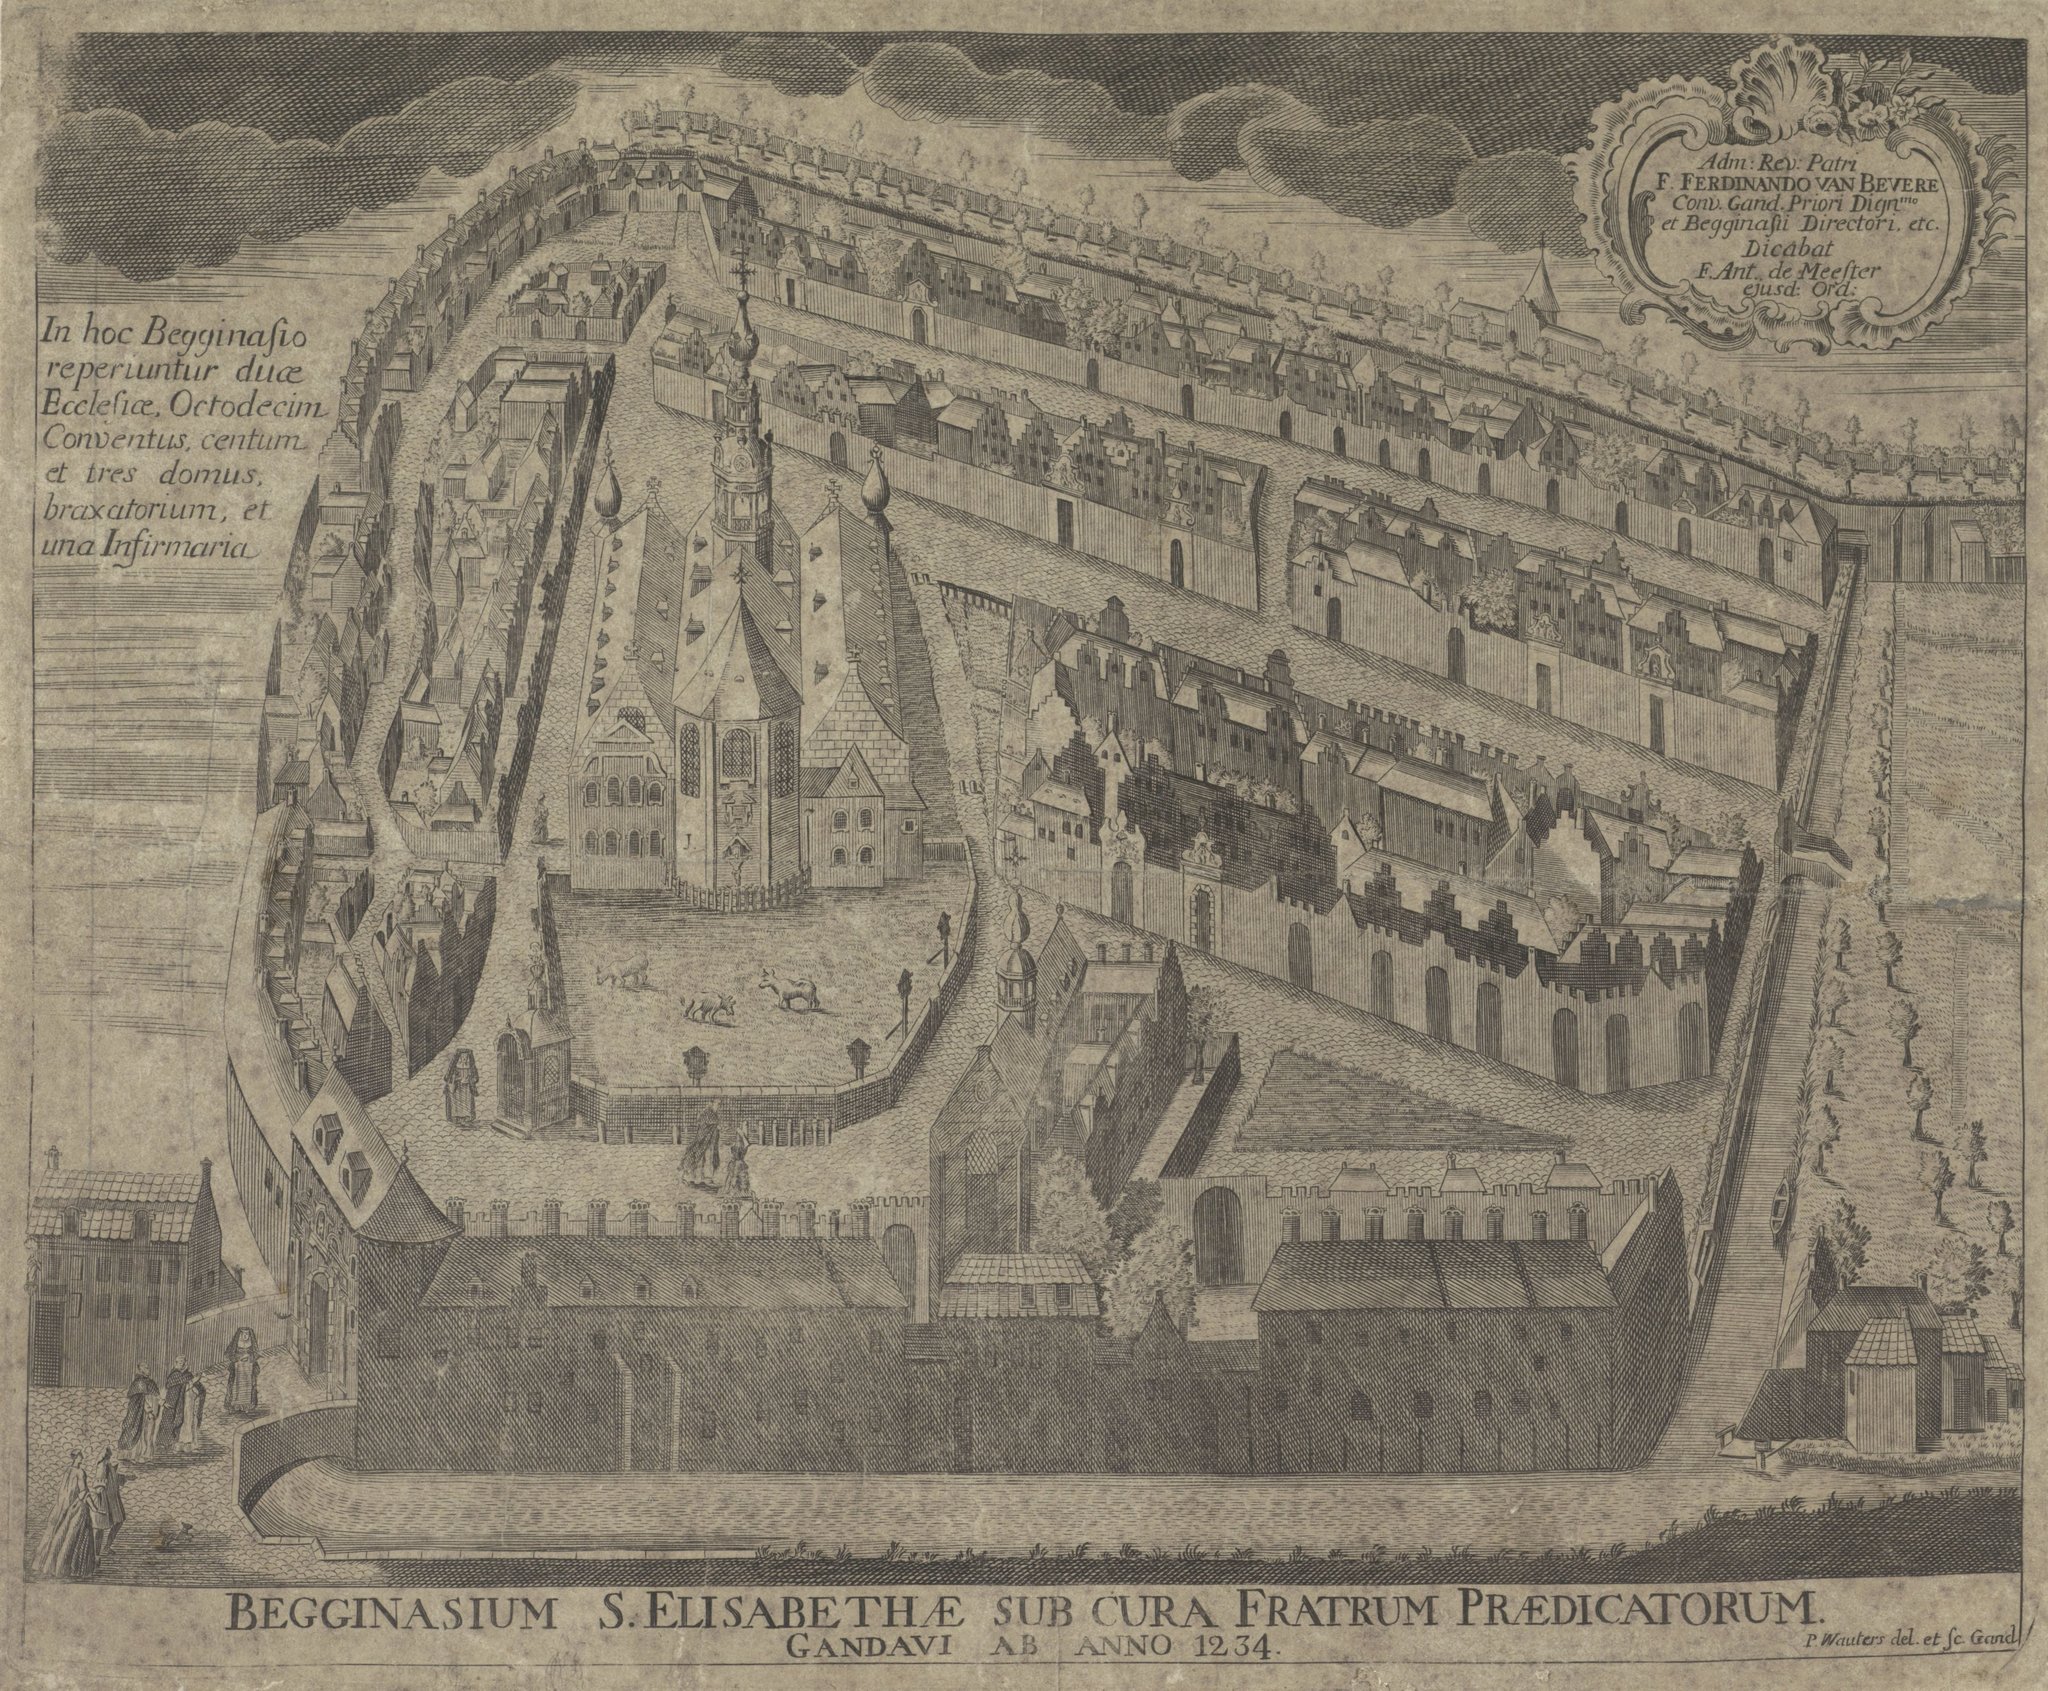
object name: print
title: Begginasium S. Elisabethæ sub cura Fratrum Prædicatorum Gandavi ab anno 1234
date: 1760-1767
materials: paper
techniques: engraving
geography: ghent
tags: church (exterior)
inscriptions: collector's mark: Lugt 2228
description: Gezicht, vanuit vogelperspectief, op het Sint-Elisabethbegijnhof en de Sint-Elisabethkerk te Gent. Rechtsboven een cartouche met een opdracht in het Latijn. Links een zevenregelig opschrift in het Latijn.